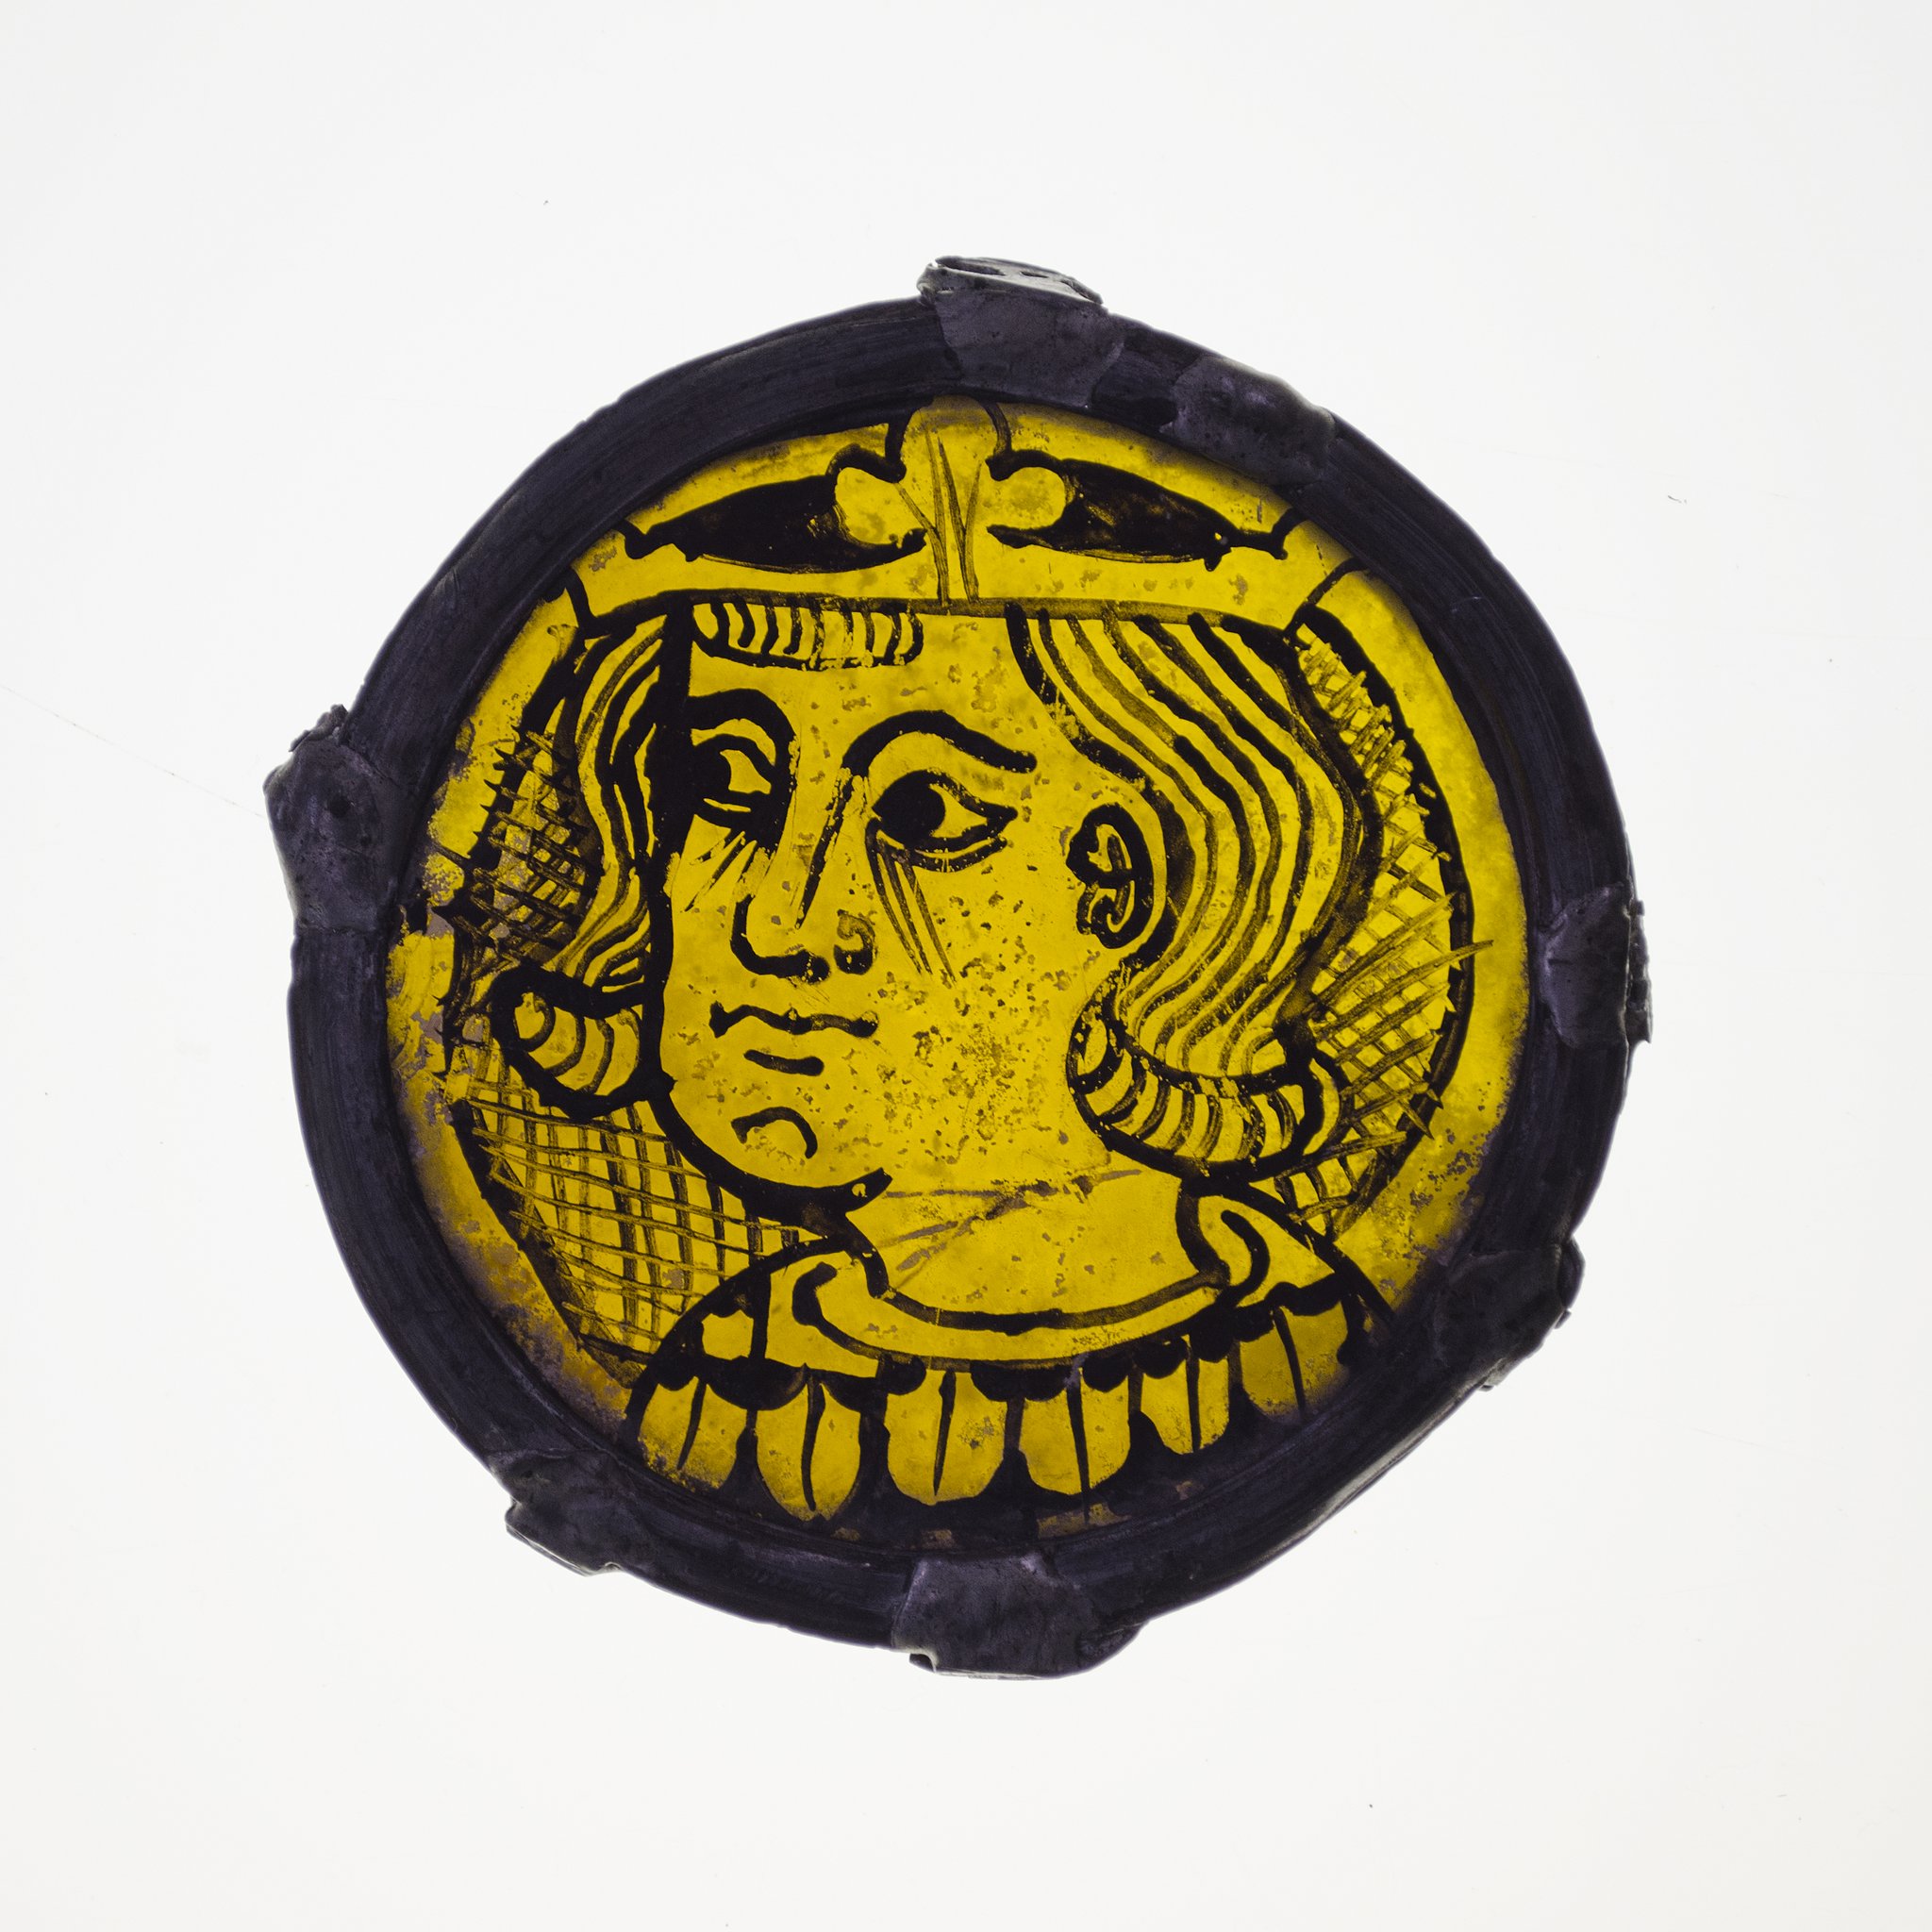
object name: fragment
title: Glass Fragment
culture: european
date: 1201-1300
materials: glass, metal